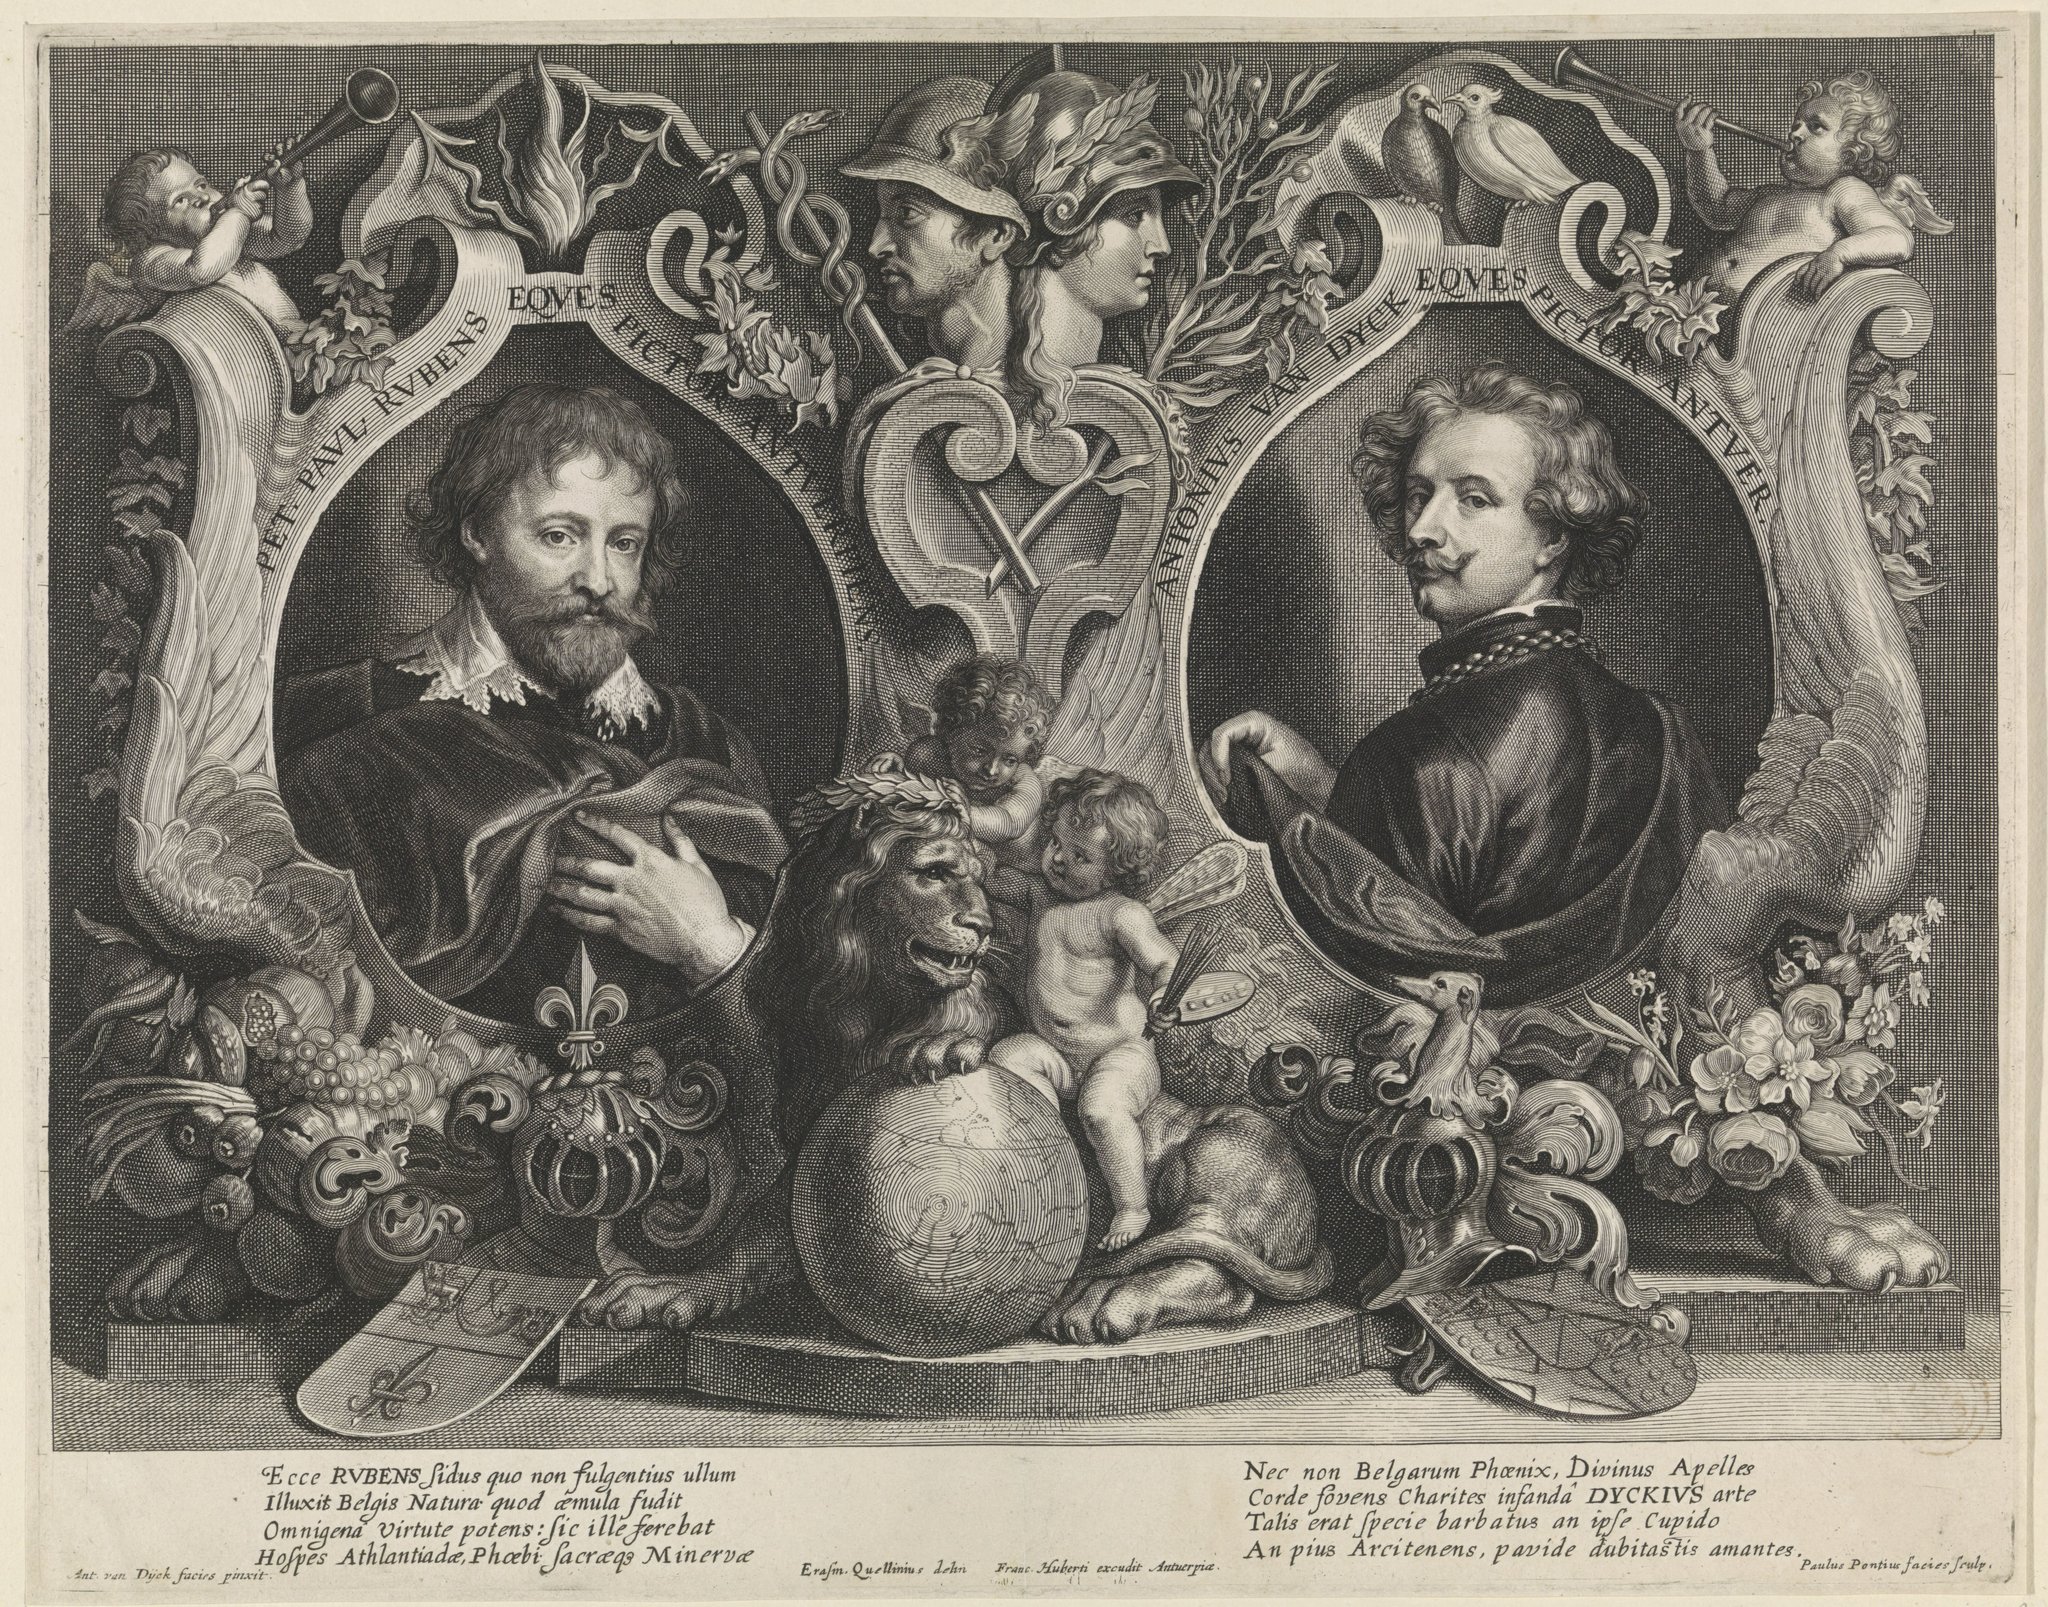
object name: print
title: Dubbelportret van de schilders Peter Paul Rubens en Anthony van Dyck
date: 1632-1687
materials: paper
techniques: engraving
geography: antwerp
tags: peter paul rubens, antwerp, painter, print maker, draughtsman, anthony van dyck, 'pictura', symbolic representations, allegories and emblems ~ painting; 'pittura' (ripa), portrait, self-portrait of painter, crowning with laurel, specific aspects, allegorical aspects of mercury; mercury as patron, specific aspects, allegorical aspects of apollo; apollo as patron, armorial bearing, heraldry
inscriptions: collector's mark: Lugt 240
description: Allegorisch dubbelportret van de schilders Peter Paul Rubens (links) en Anthony van Dyck (rechts). In het midden de koppen van Mercurius en Apollo. Op de voorgrond lauweren twee putti met schilderattributen een leeuw. In de marge onder elk portret een vierregelig lofdicht in het Latijn.